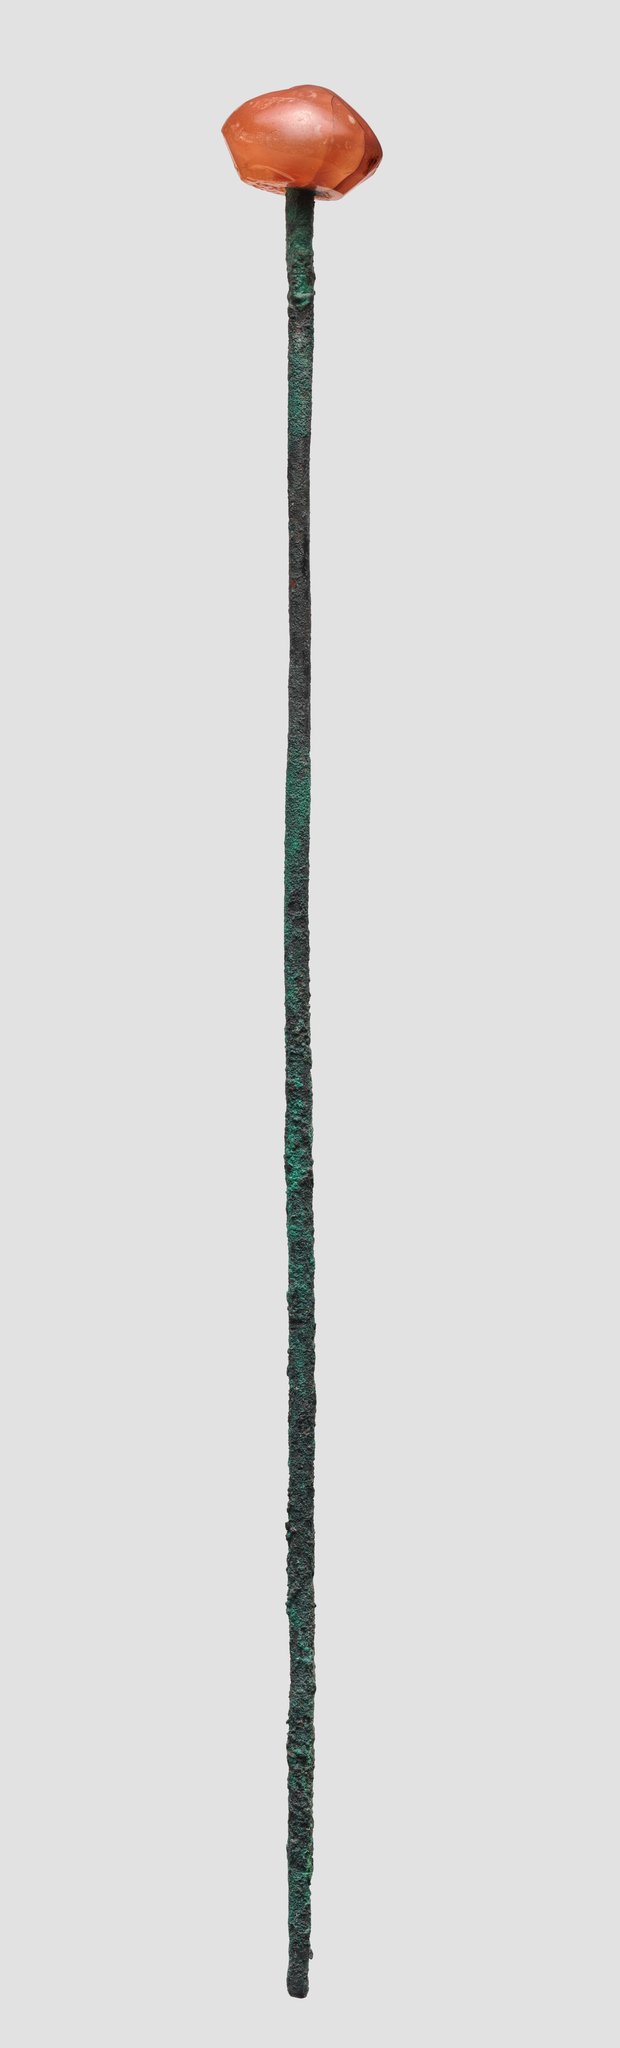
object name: pin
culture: iranian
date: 900-801 BCE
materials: bronze, gemstone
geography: iran